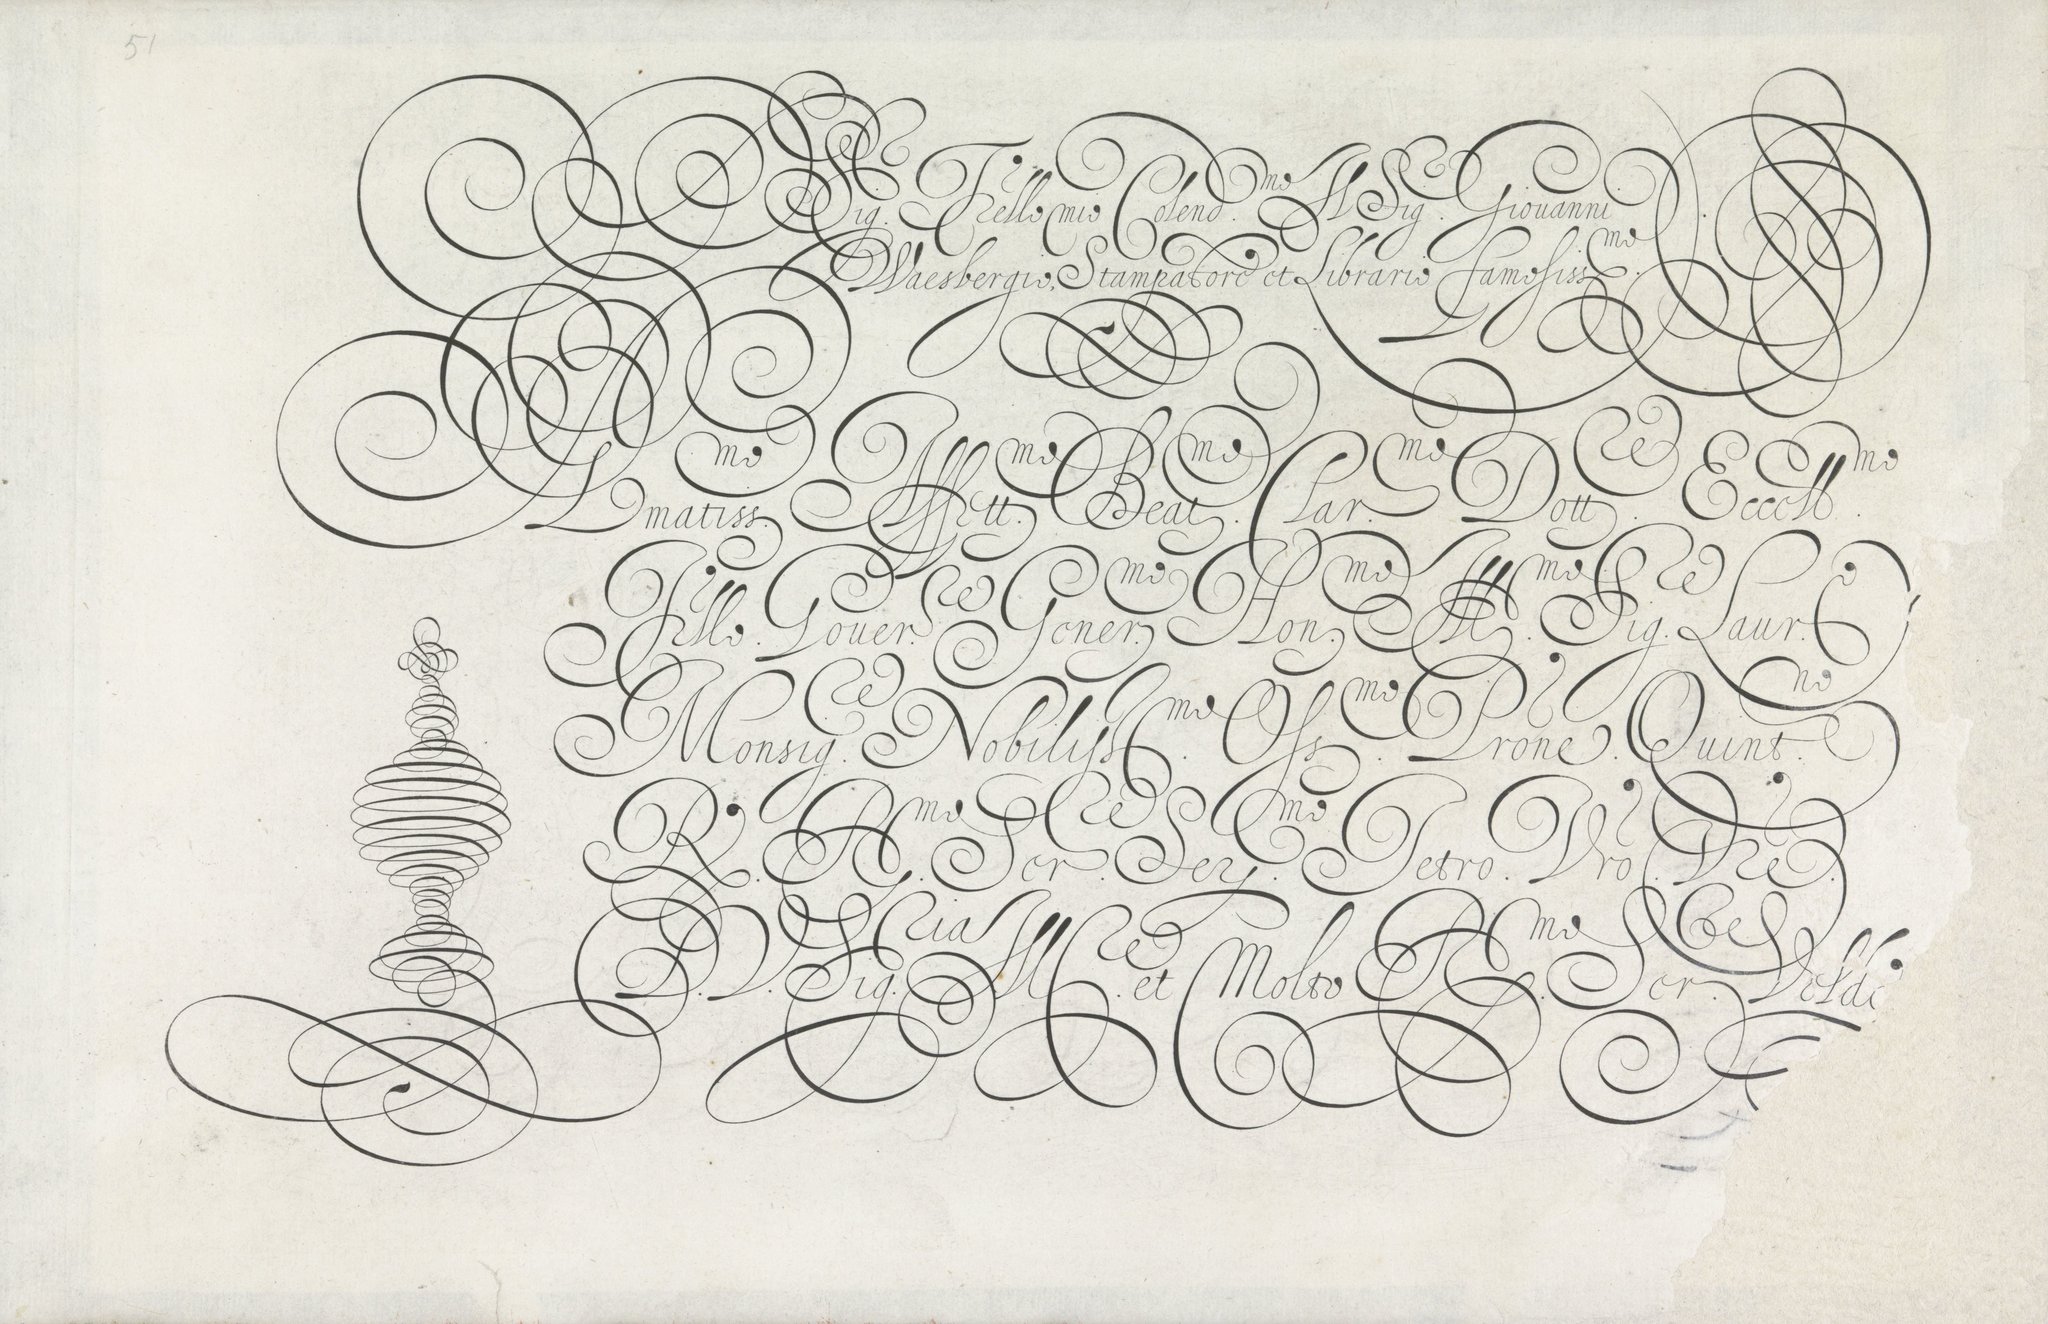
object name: ornament print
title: Schrijfvoorbeeld: Sig. fr[at]ello mio (...).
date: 1605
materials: paper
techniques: engraving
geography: haarlem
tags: calligraphy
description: Schrijfvoorbeeld met de aanhef: Sig. fr[at]ello mio colend. il sig. Giovanni Waesbergio ... Daaronder zes regels tekst in het Latijn, voornamelijk bestaande uit afkortingen: Amo ... Links een vaas of ciborie in krulwerk. De prent maakt deel uit van een album.